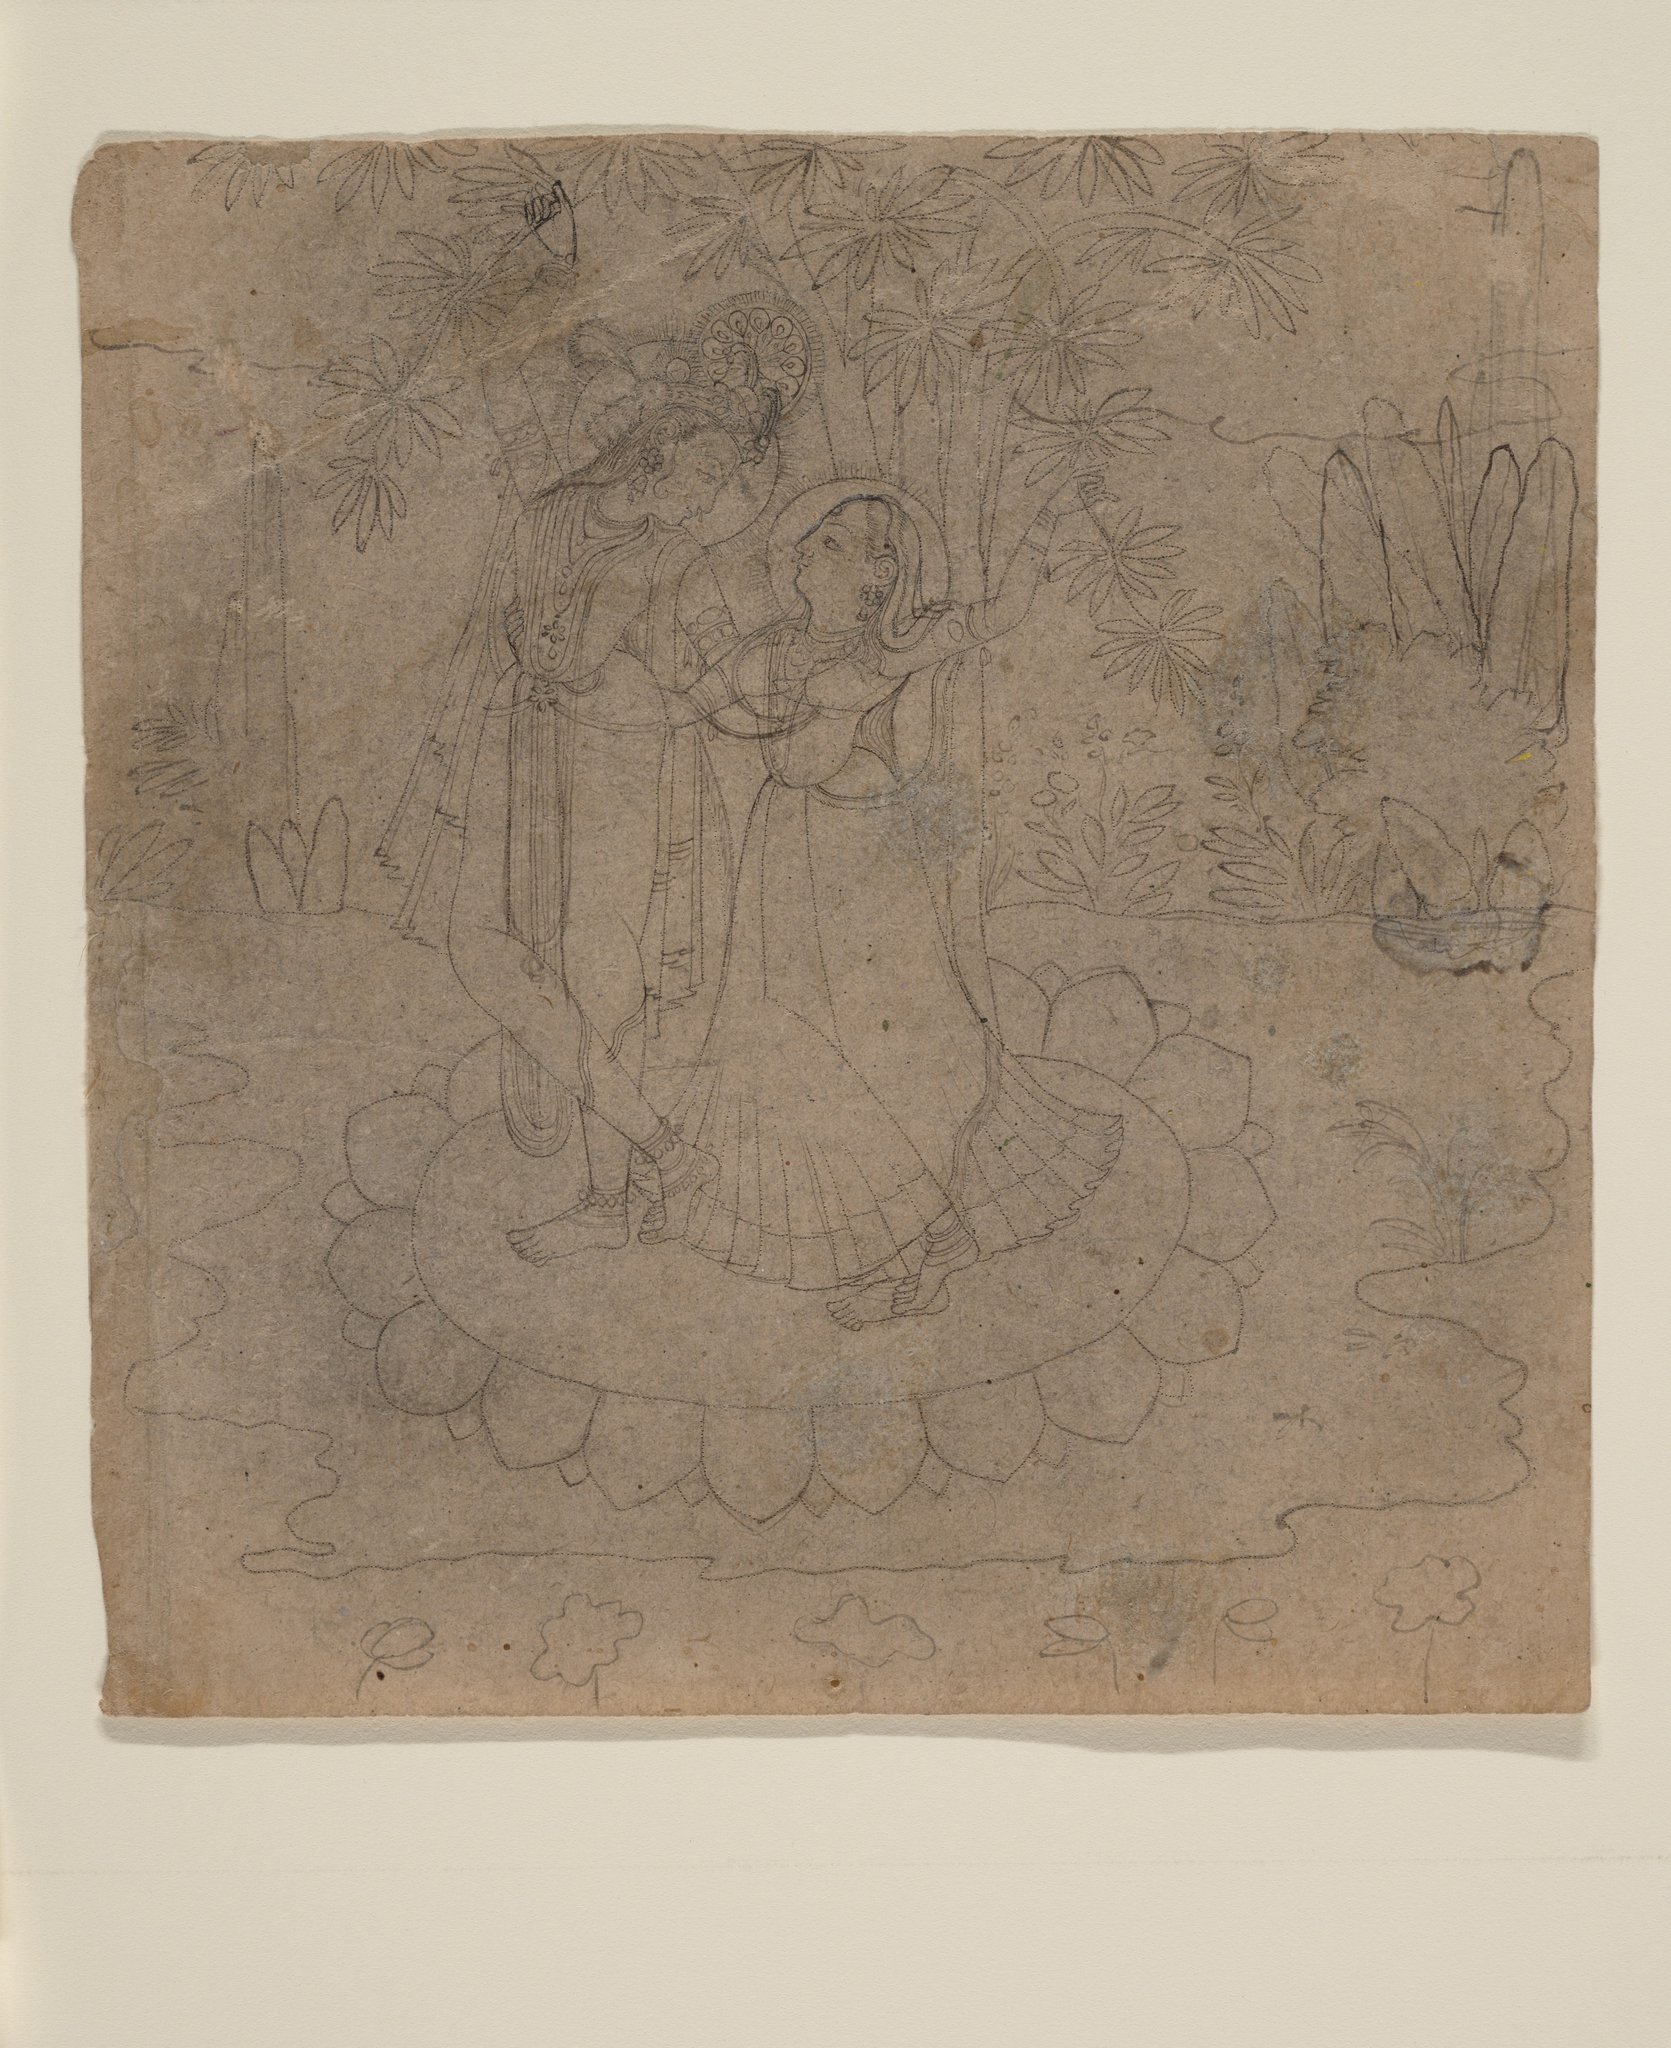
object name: drawing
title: Krishna and Radha Standing on a Lotus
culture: indian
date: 1867-1933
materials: ink, paper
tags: krishna,radha